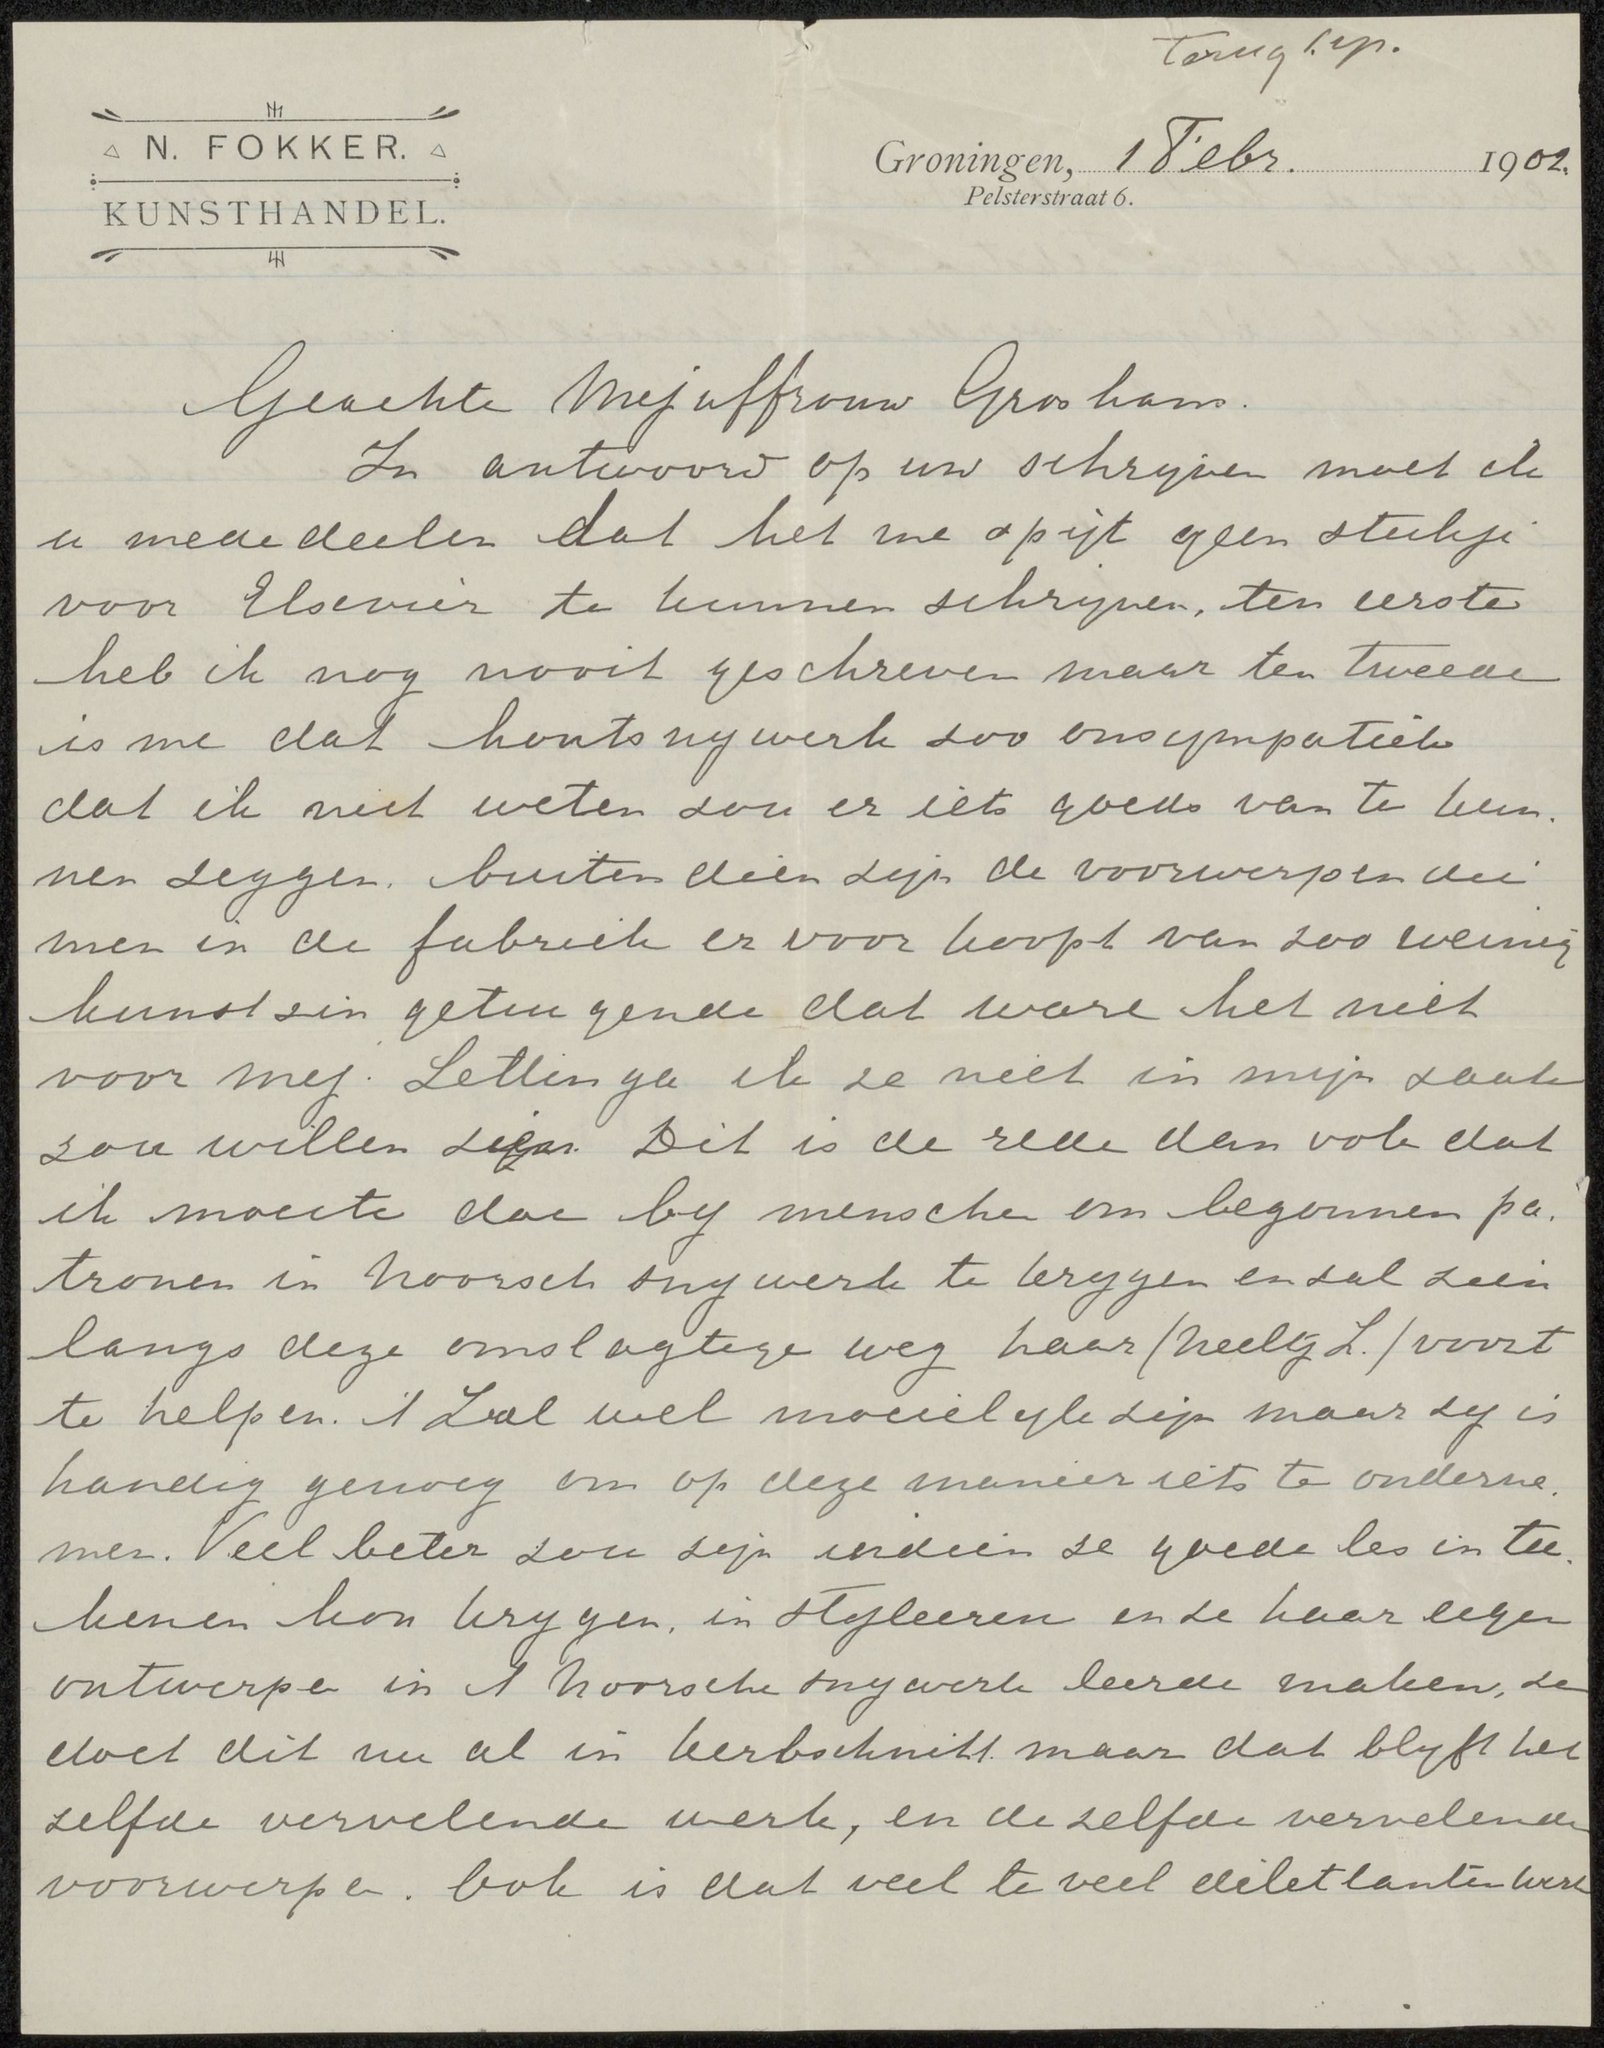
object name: letter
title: Brief aan Suze Groshans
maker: nelly fokker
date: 1902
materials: ink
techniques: pen, printing, writing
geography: groningen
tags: suze groshans, textile artist, neeltje lettinga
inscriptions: name: ‘RPK’, collector's mark: ‘RPK’